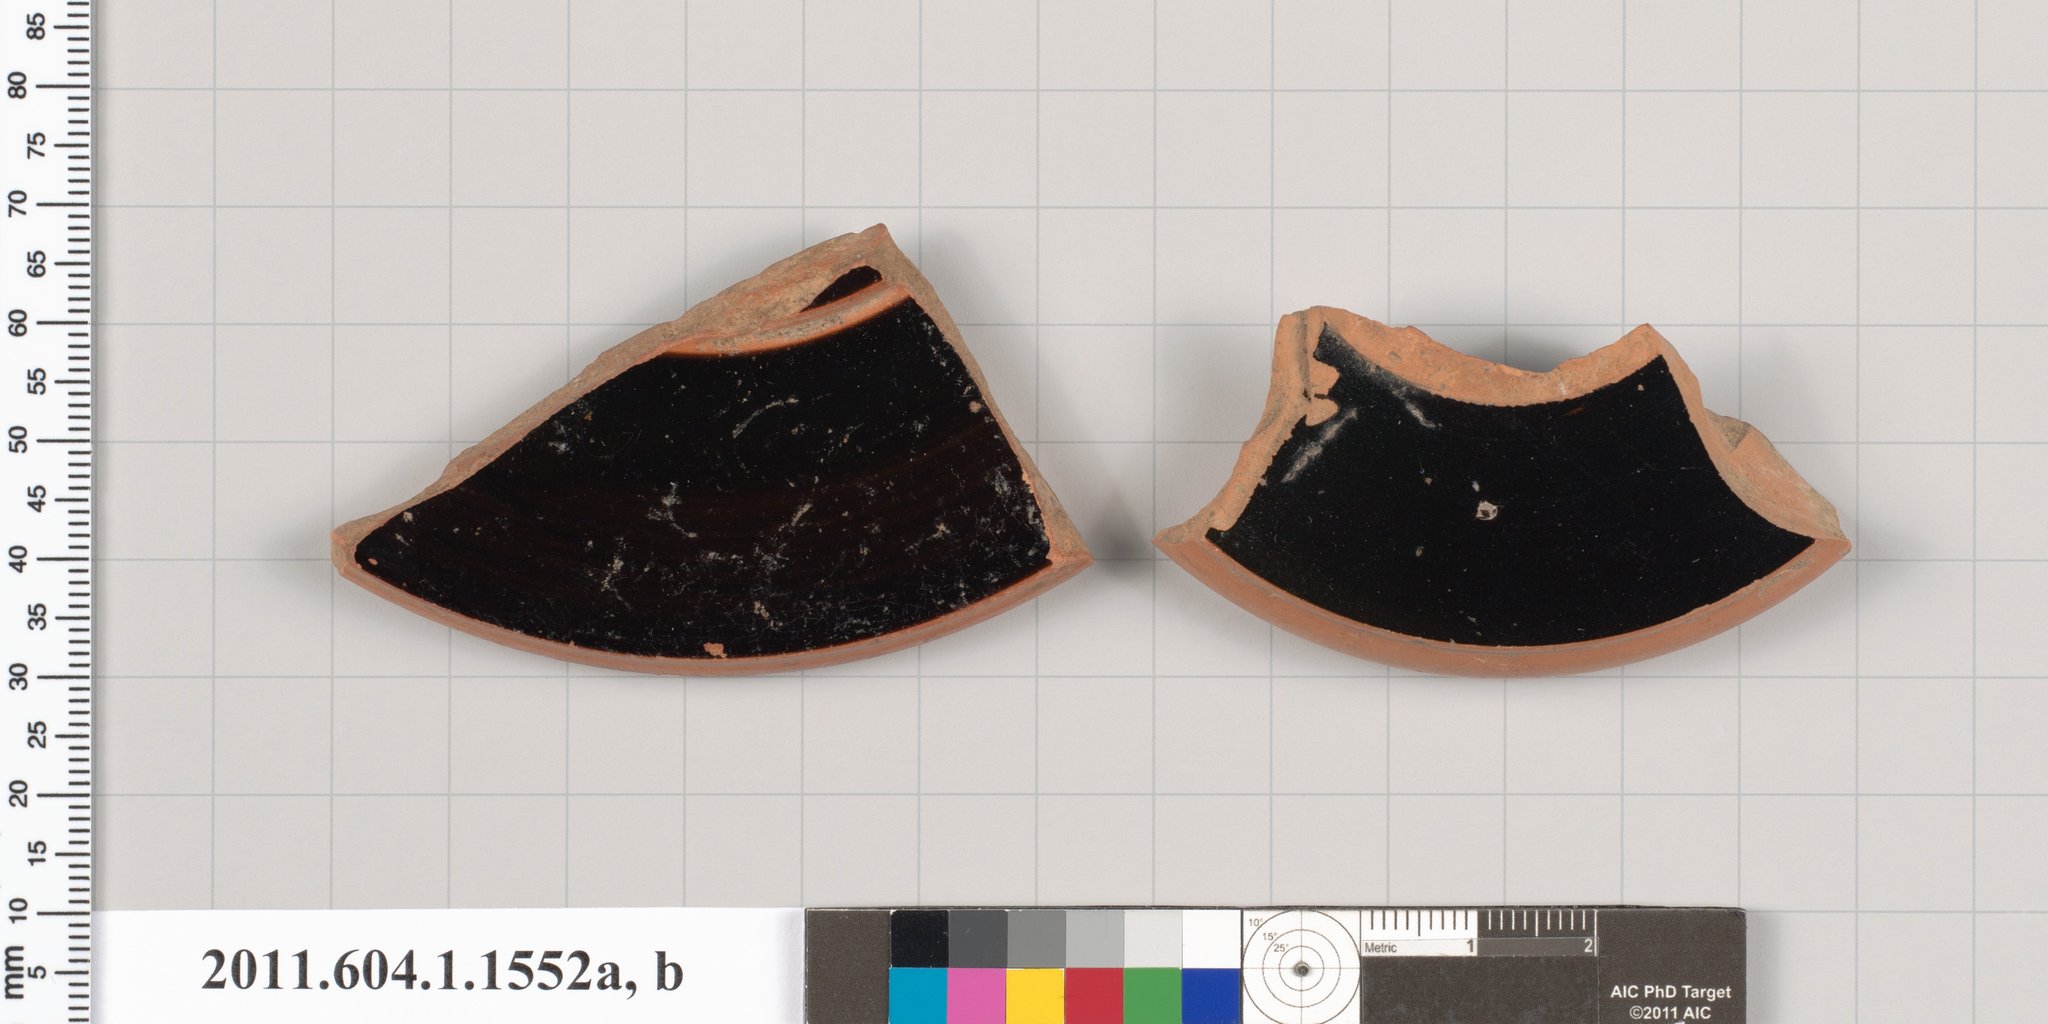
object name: kylix fragment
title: Terracotta fragments of kylikes (drinking cups)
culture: greek, attic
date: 500-401 BCE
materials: terracotta